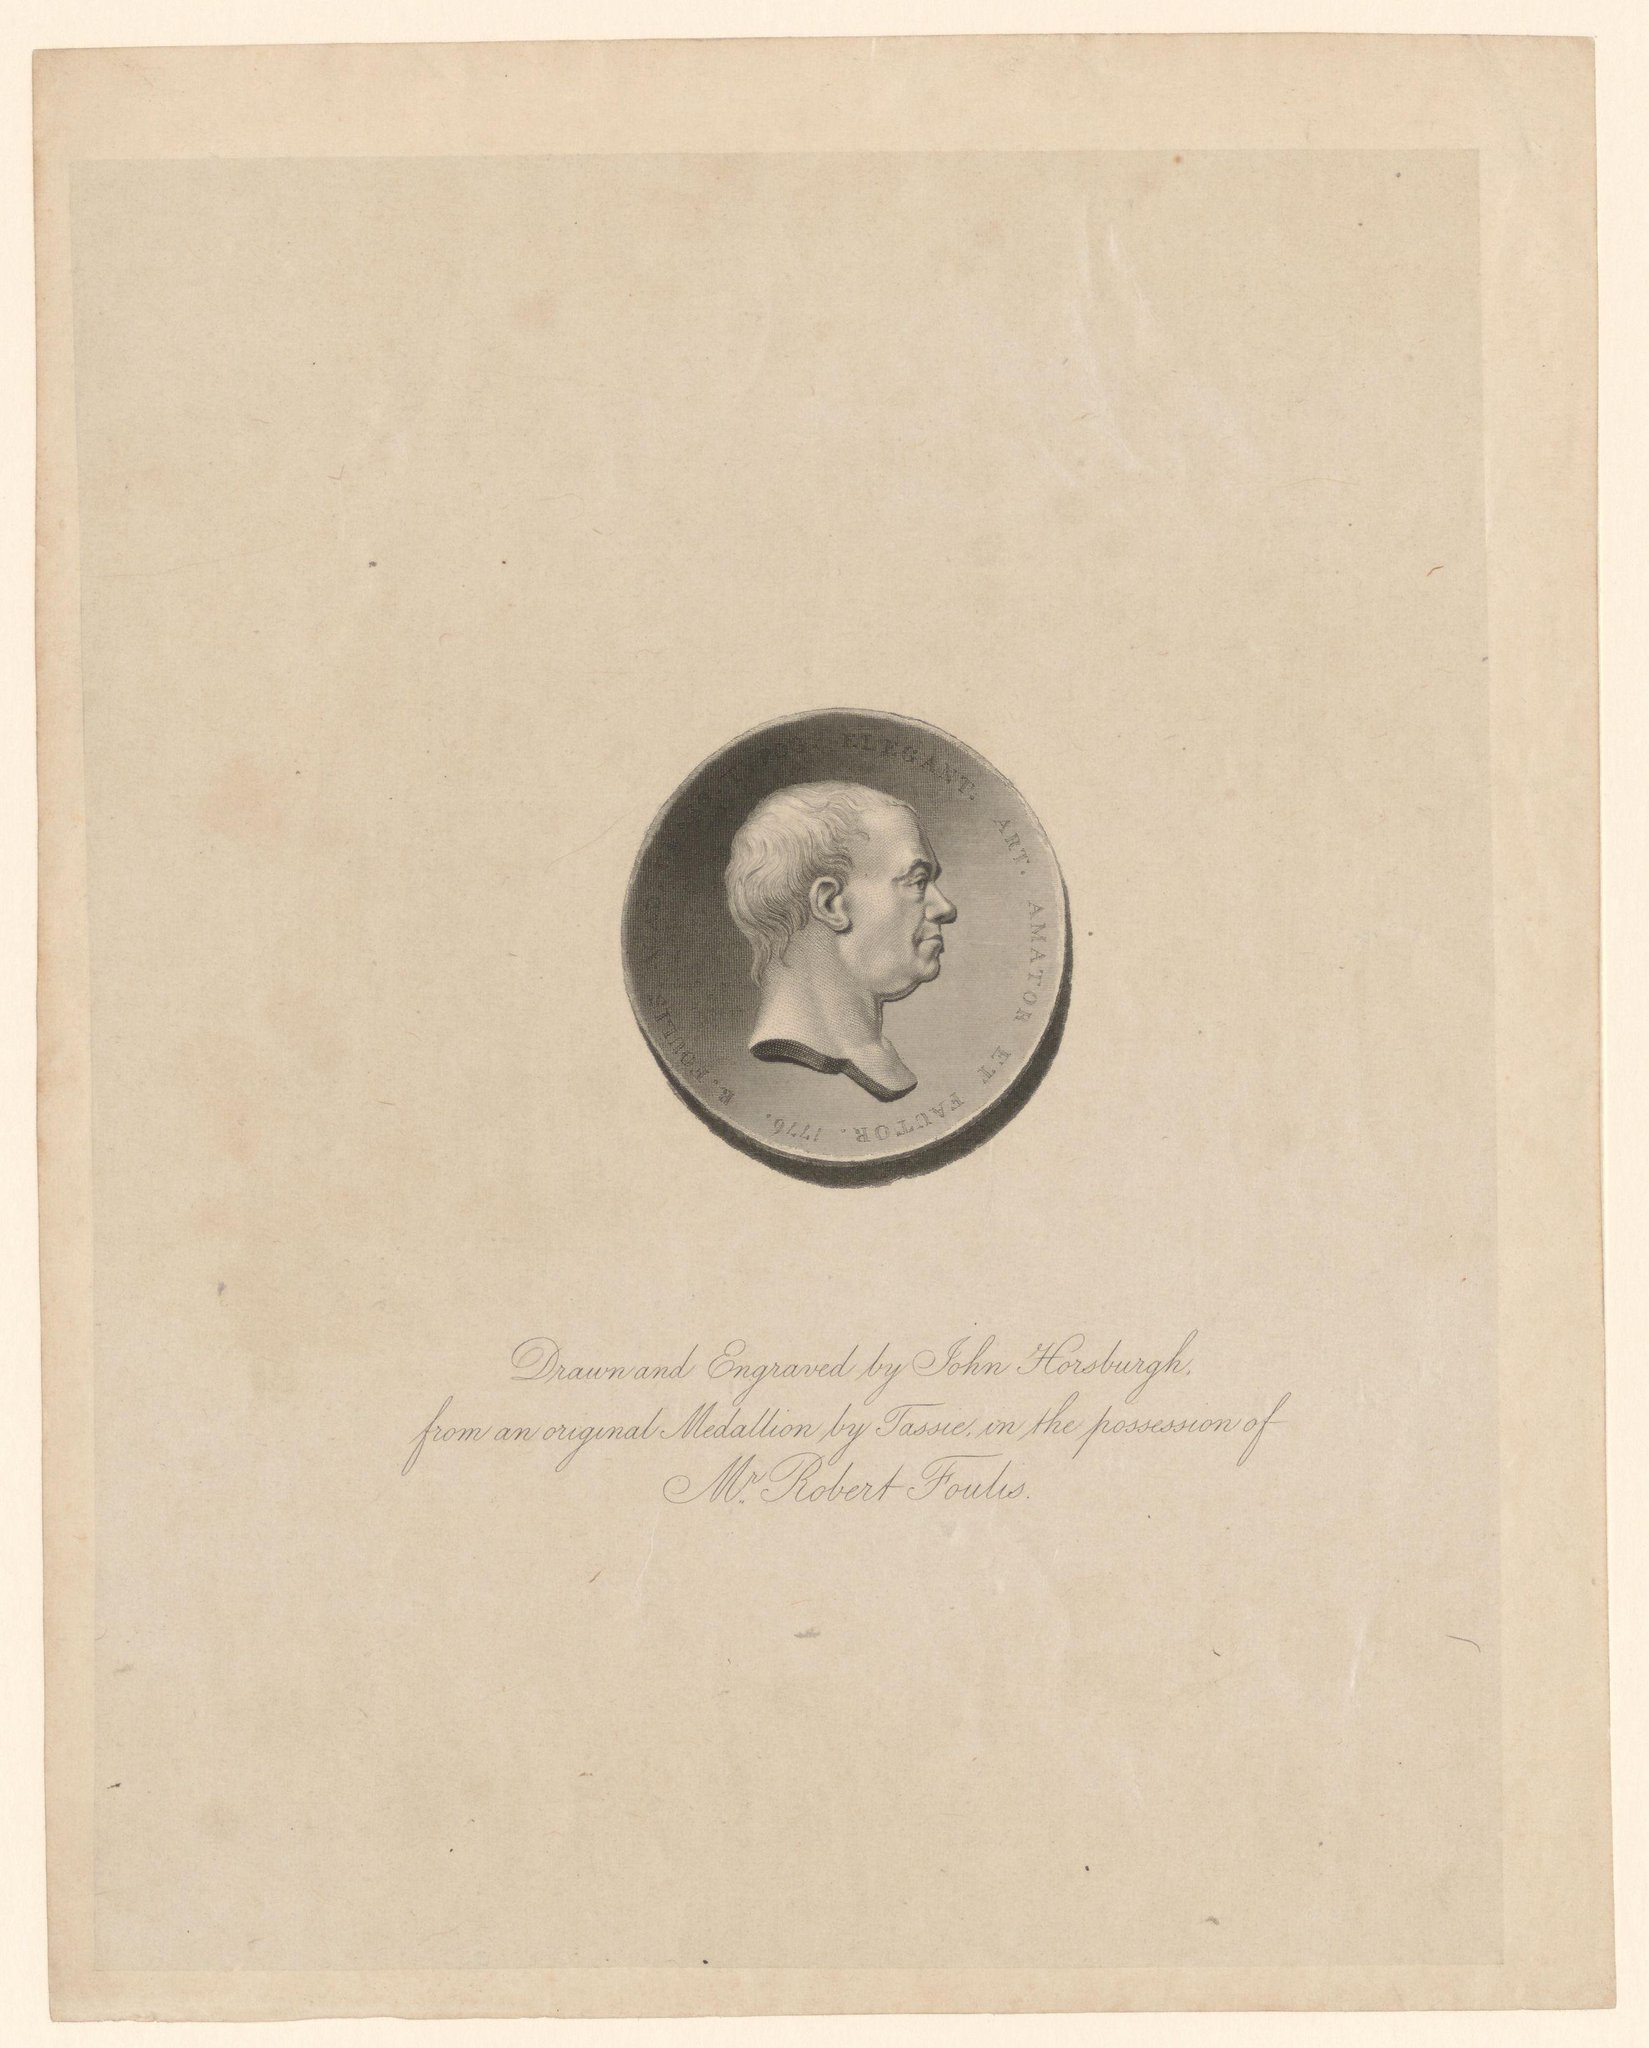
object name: print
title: Portret van Robert Foulis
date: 1776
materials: paper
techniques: engraving, etching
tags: publishing, publisher (+ portrait of scholar, scientist), historical persons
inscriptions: collector's mark: Lugt 2228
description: Tekst in het Latijn in de omlijsting van het medaillon en in de ondermarge.